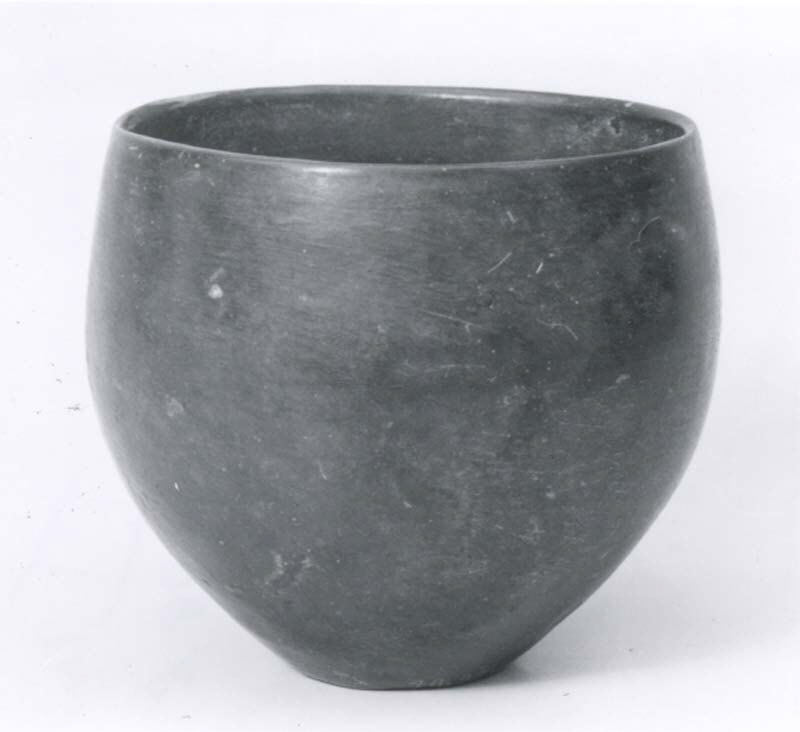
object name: cup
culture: iranian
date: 3365-3030 BCE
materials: ceramic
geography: iran